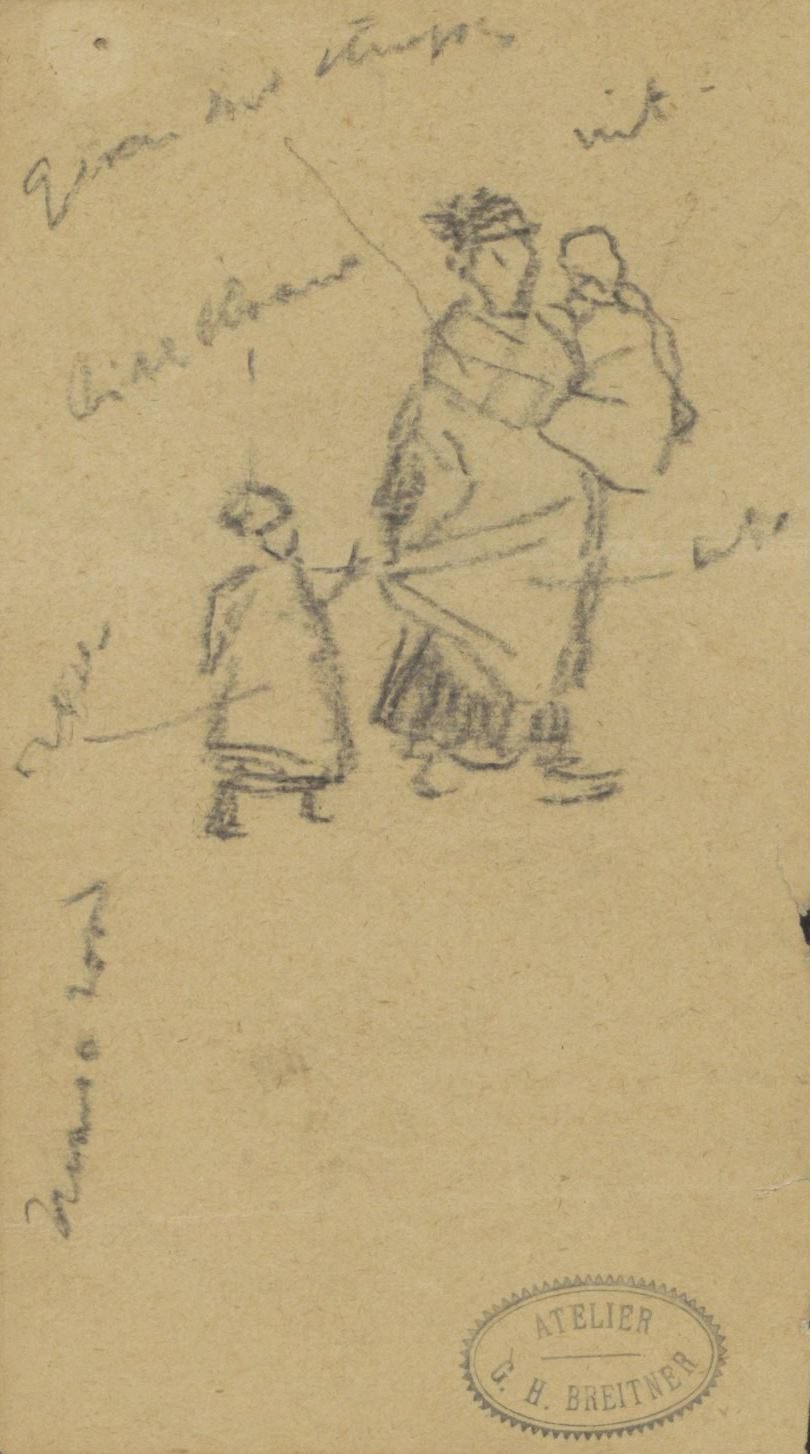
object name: drawing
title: Vrouw met twee kinderen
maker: george hendrik breitner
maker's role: draughtsman, painter, print maker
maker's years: 1857-1923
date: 1886-1923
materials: charcoal, paper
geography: amsterdam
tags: mother and child(ren), woman and child(ren) (family group)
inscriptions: collector's mark: Lugt 2228, annotation: ‘Mathijs/ Maris’, workshop stamp: Lugt 291d, :